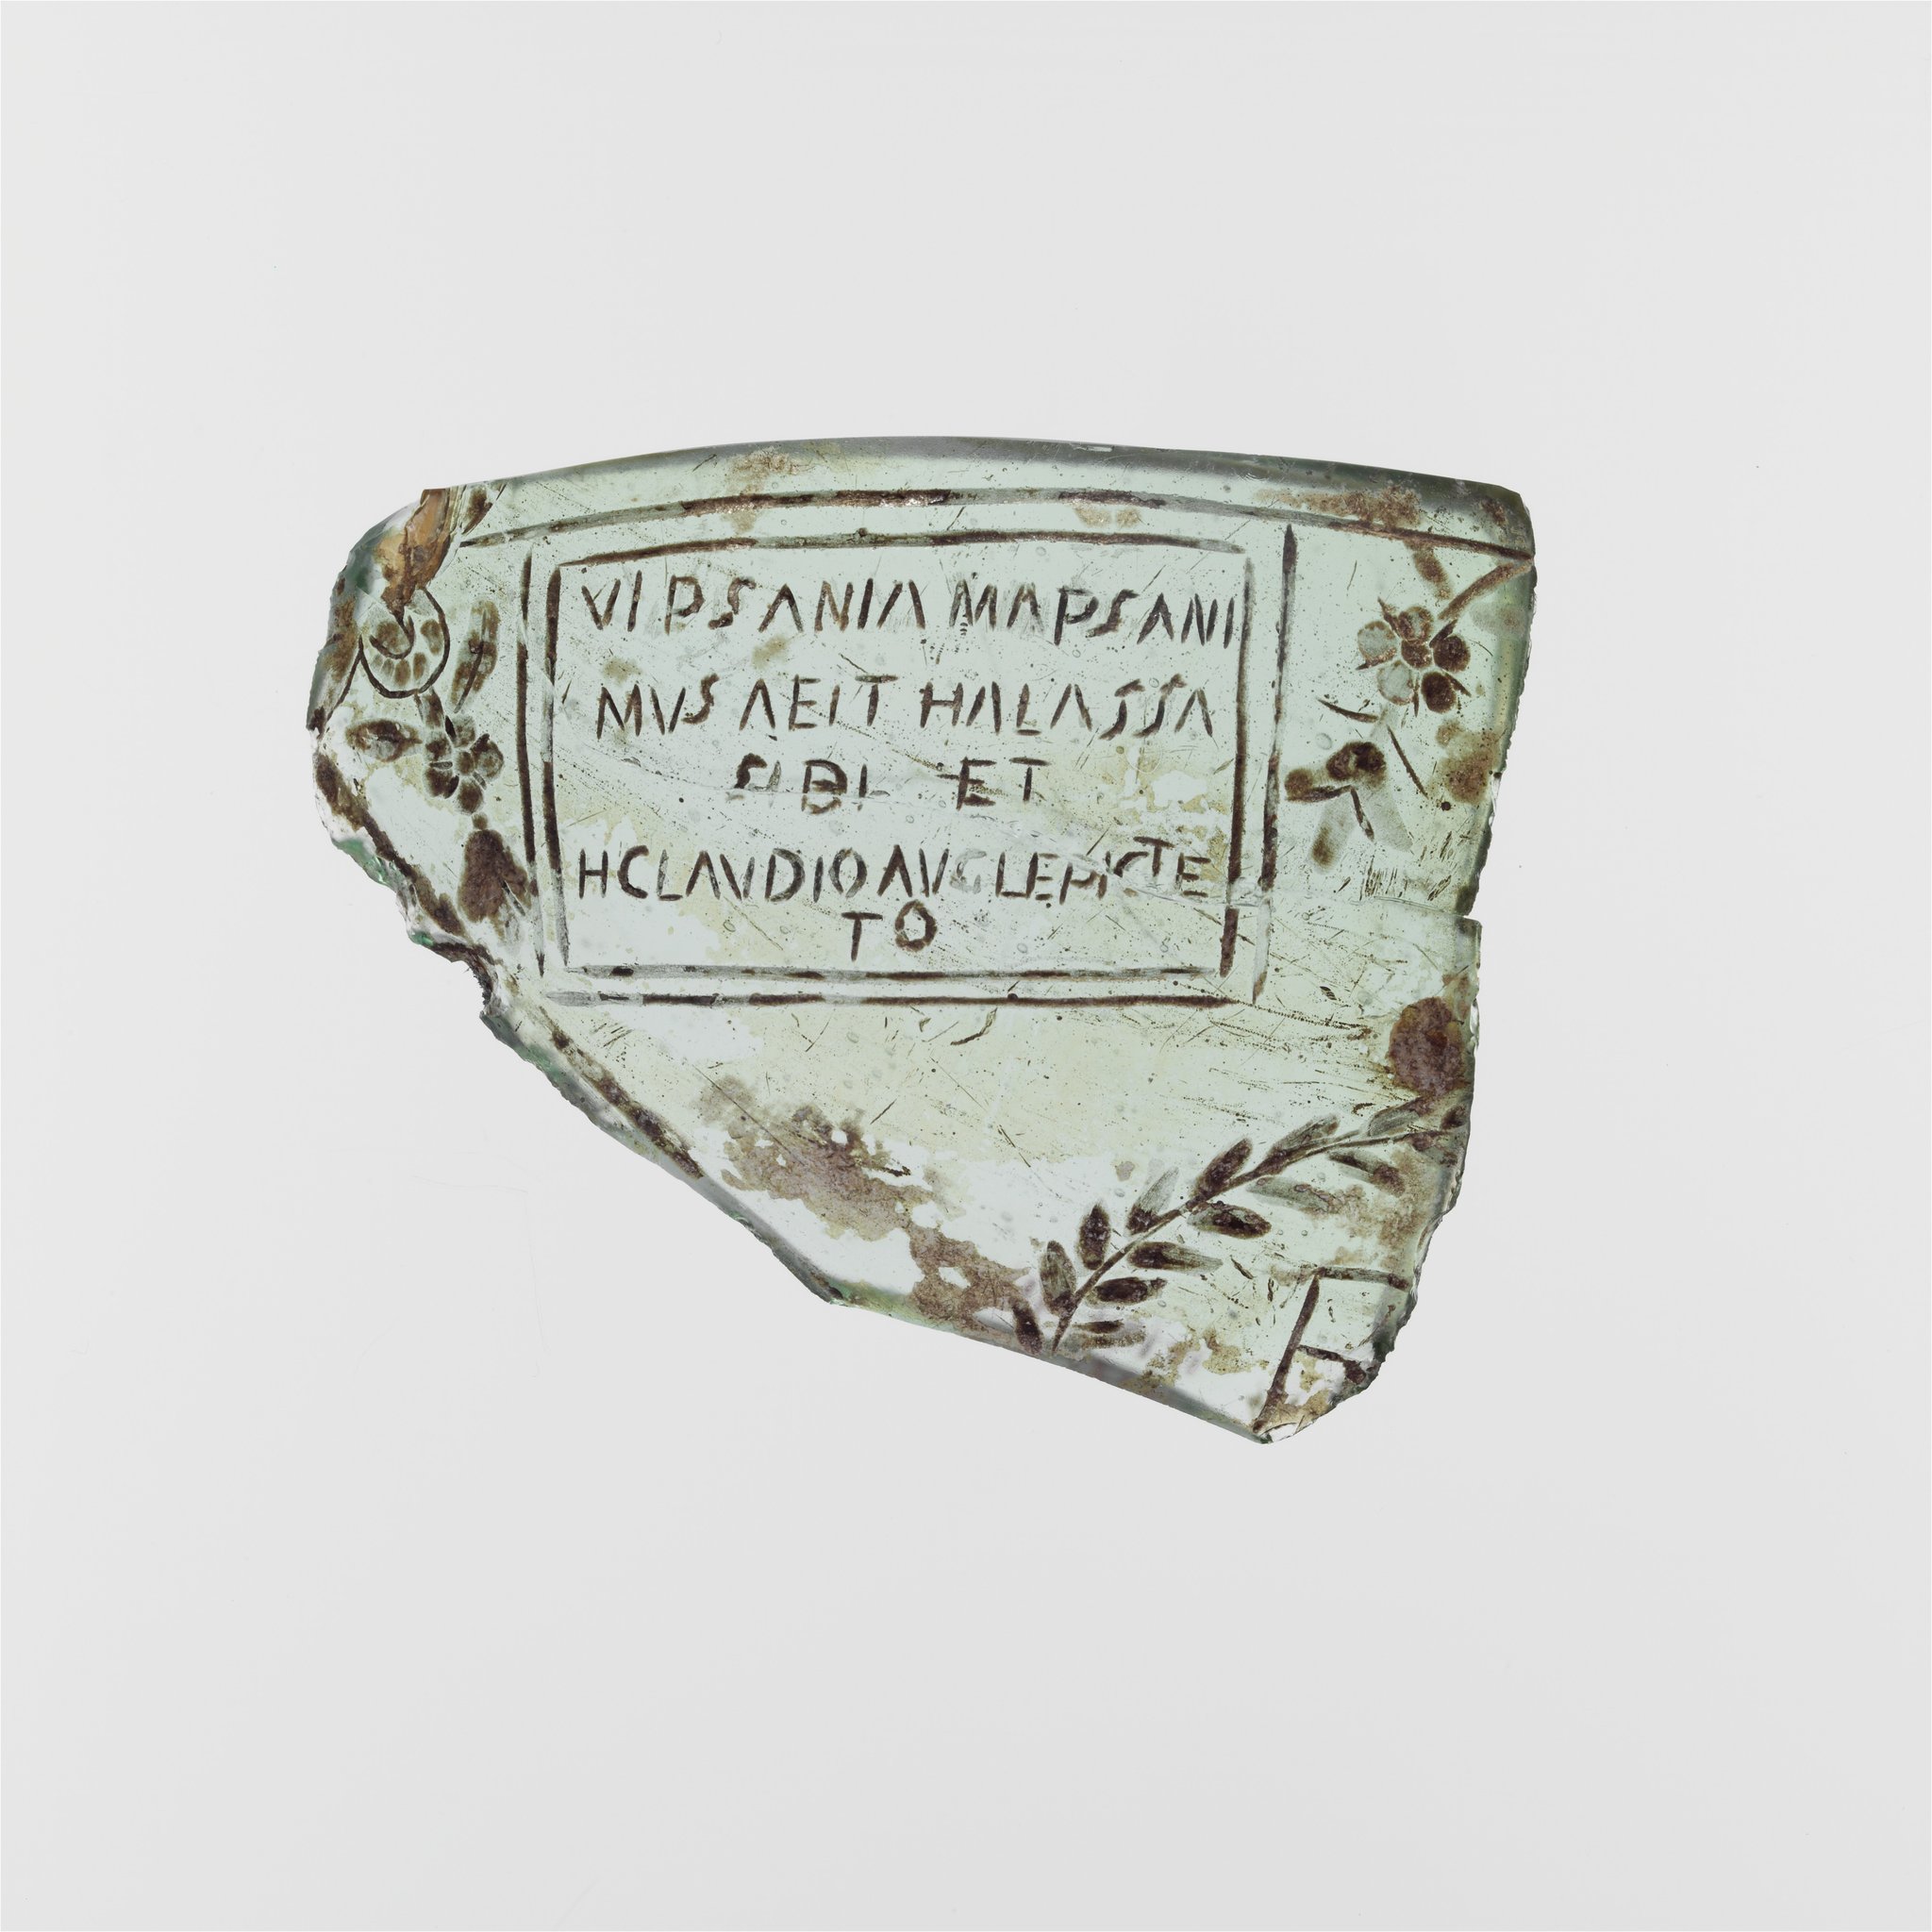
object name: fragment of a bowl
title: Glass bowl fragment with later inscription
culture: roman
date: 1-300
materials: glass